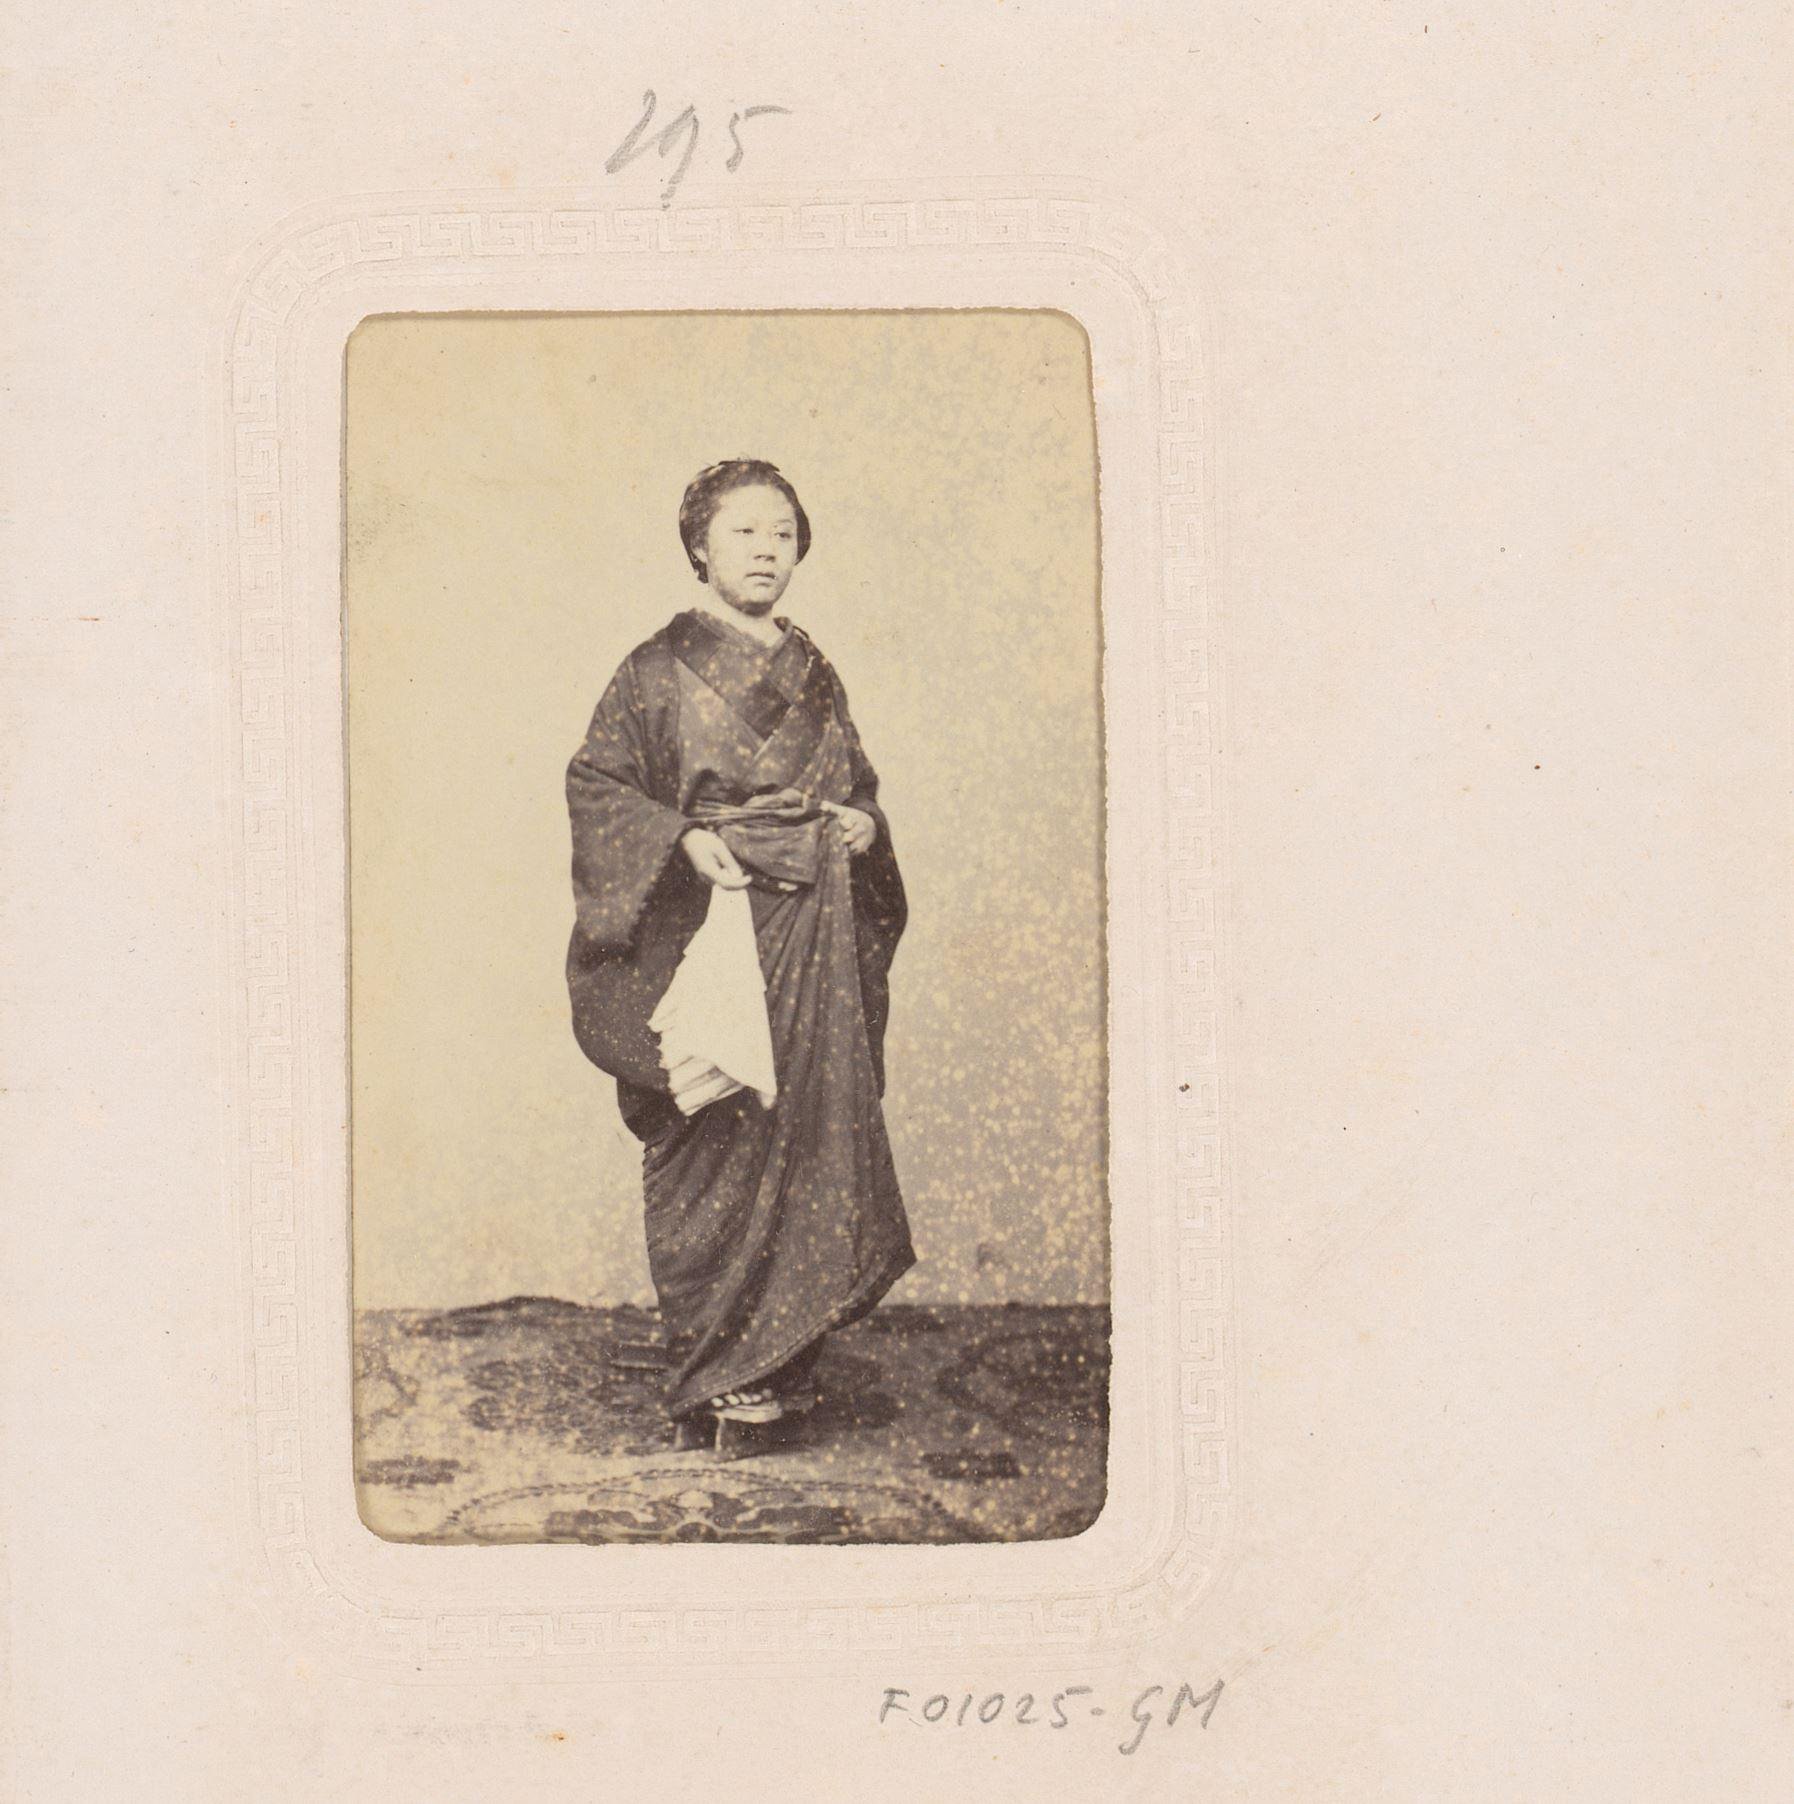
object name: album leaf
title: Portret van een Japanse vrouw met witte doek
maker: Anonymous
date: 1850-1880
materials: cardboard, photographic support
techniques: albumen print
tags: adult woman, historical persons - bb - woman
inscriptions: number: ‘195’